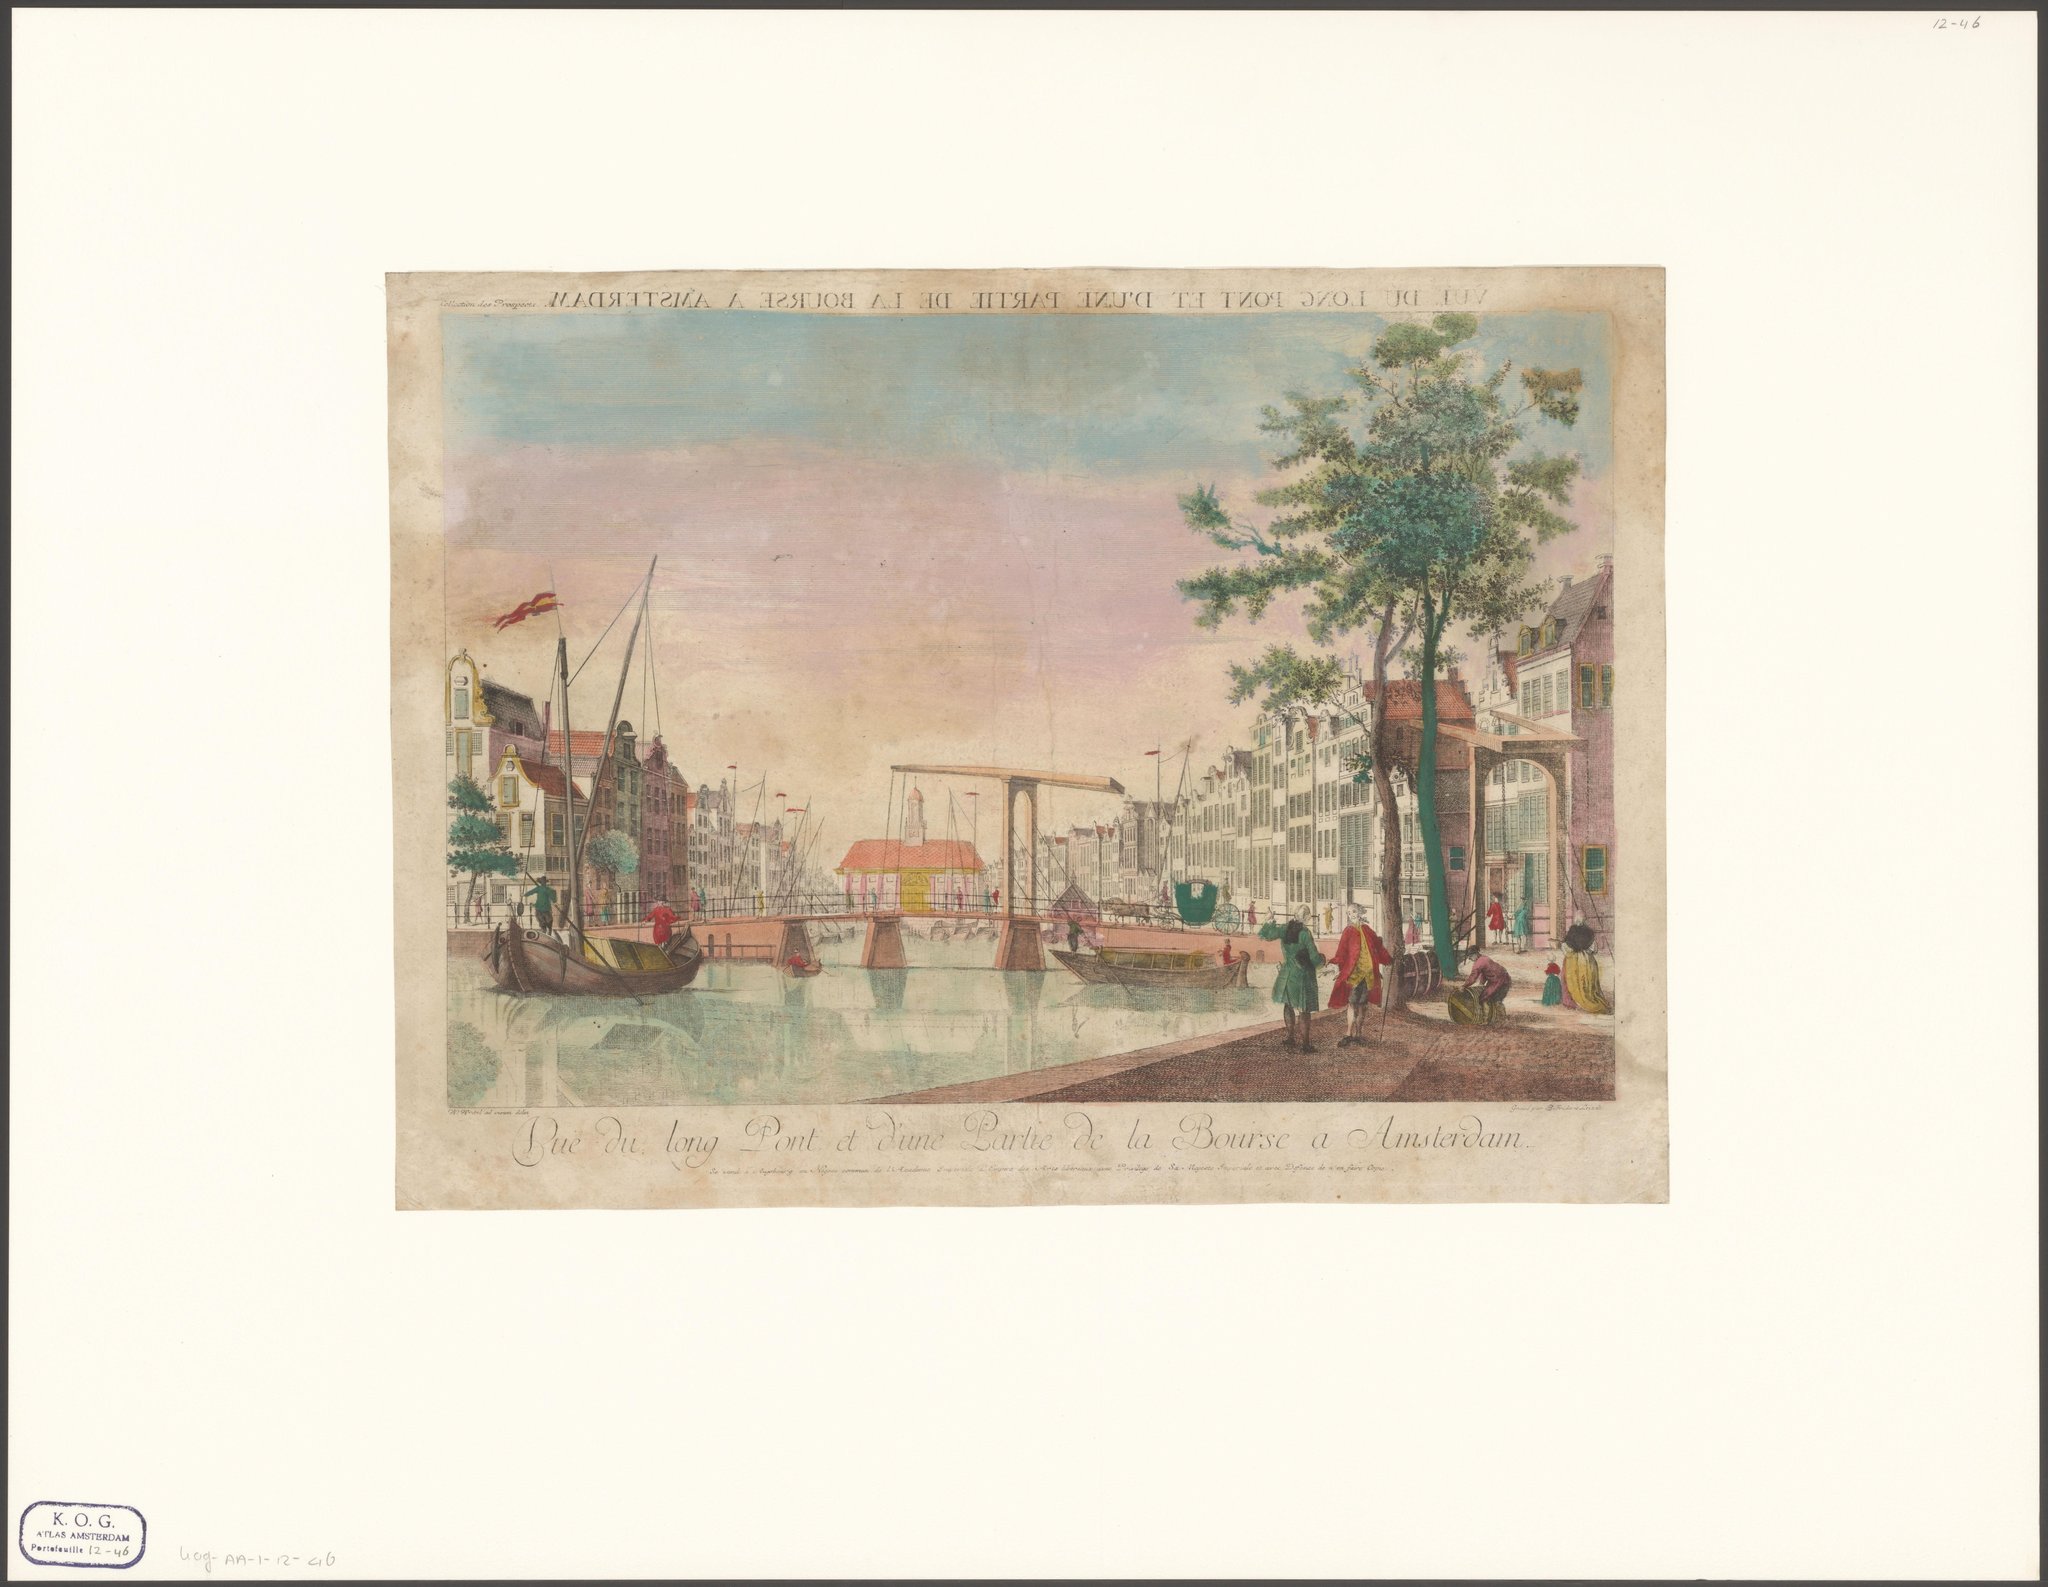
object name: print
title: Vuë du Long Pont et d'une partie de la Bourse a Amsterdam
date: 1775-1779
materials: paper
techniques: etching, hand coloring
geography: augsburg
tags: city-view in general; 'veduta', canal, bridge in city across river, canal, etc., market-hall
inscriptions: collector's mark: ‘12-46’ Lugt 1641b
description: Onderwerpsrubriek binnen de Atlas Amsterdam: Rokin, Rotterdammersloot, Rozengang, Rozengracht, Rozenstraat, Rusland, Rustenburgerstraat, Ruysdaelkade, Ruysdaelstraat, Ruyterkade (de), Ruyterweg (Admiraal de).